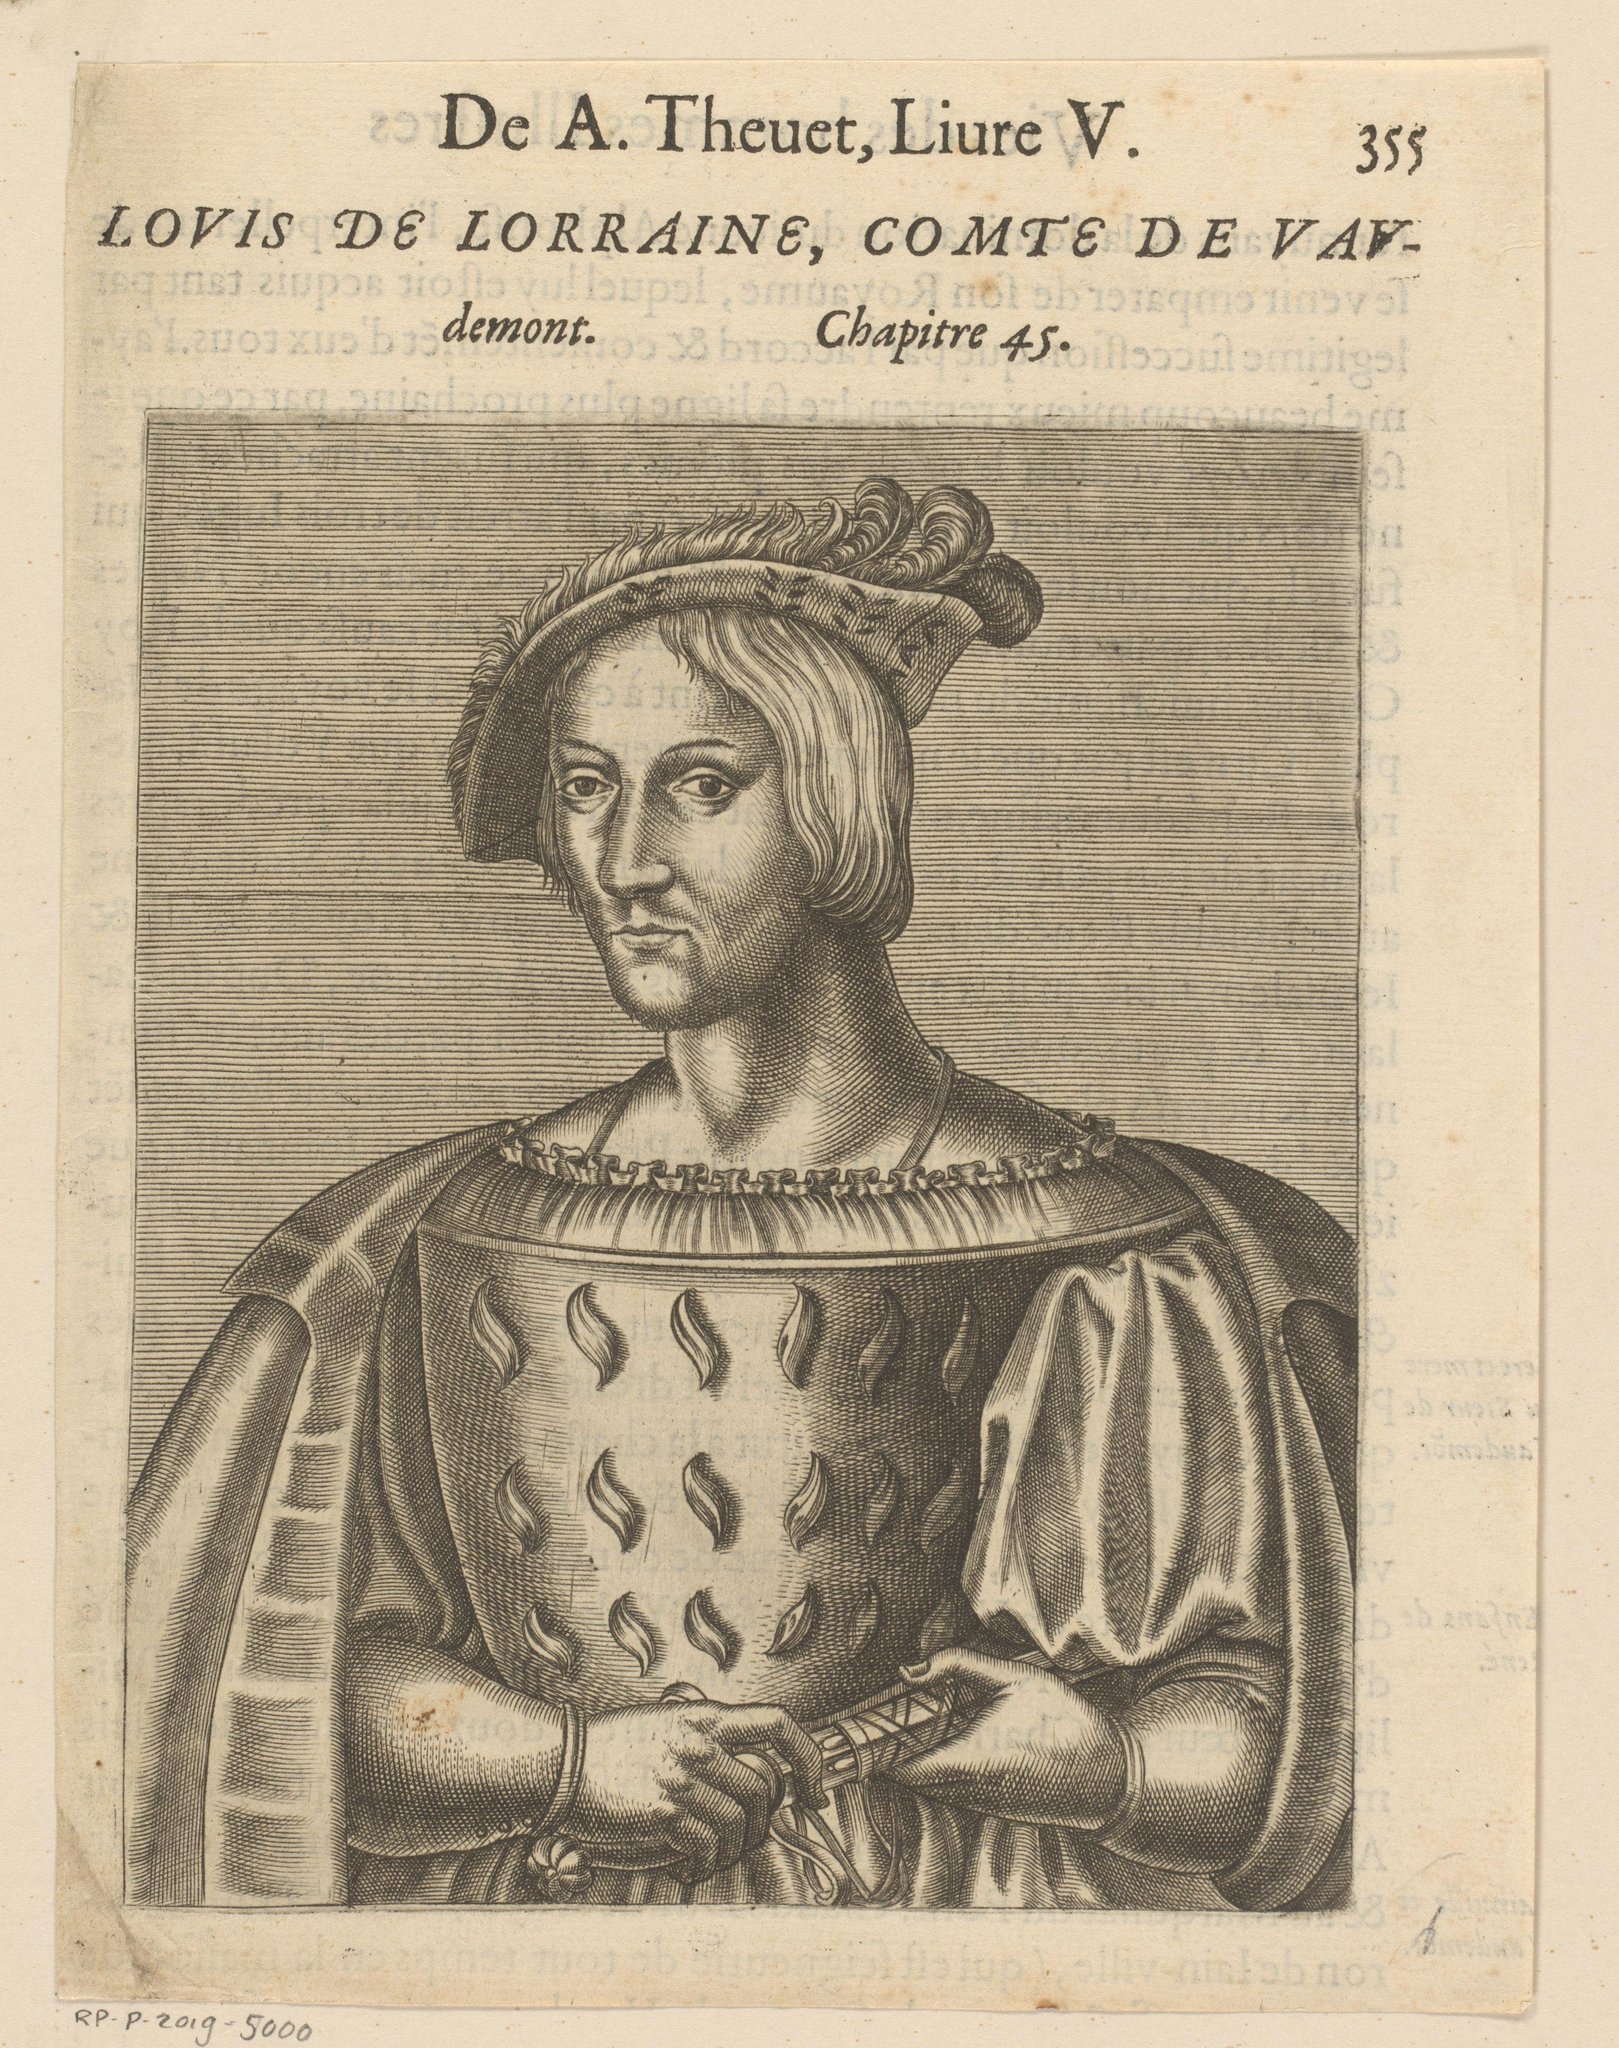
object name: book illustration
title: Portret van Lodewijk van Lotharingen, graaf van Vaudémont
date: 1584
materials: paper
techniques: engraving, letterpress printing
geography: paris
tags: earl, historical persons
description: Prent uit: Thevet, André. Les vrais pourtraits et vies des hommes illustres grecz, latins et payens (...). Parijs: weduwe Jacques Kerver en Guillaume Chaudière, 1584, dl. 2, f. 355.